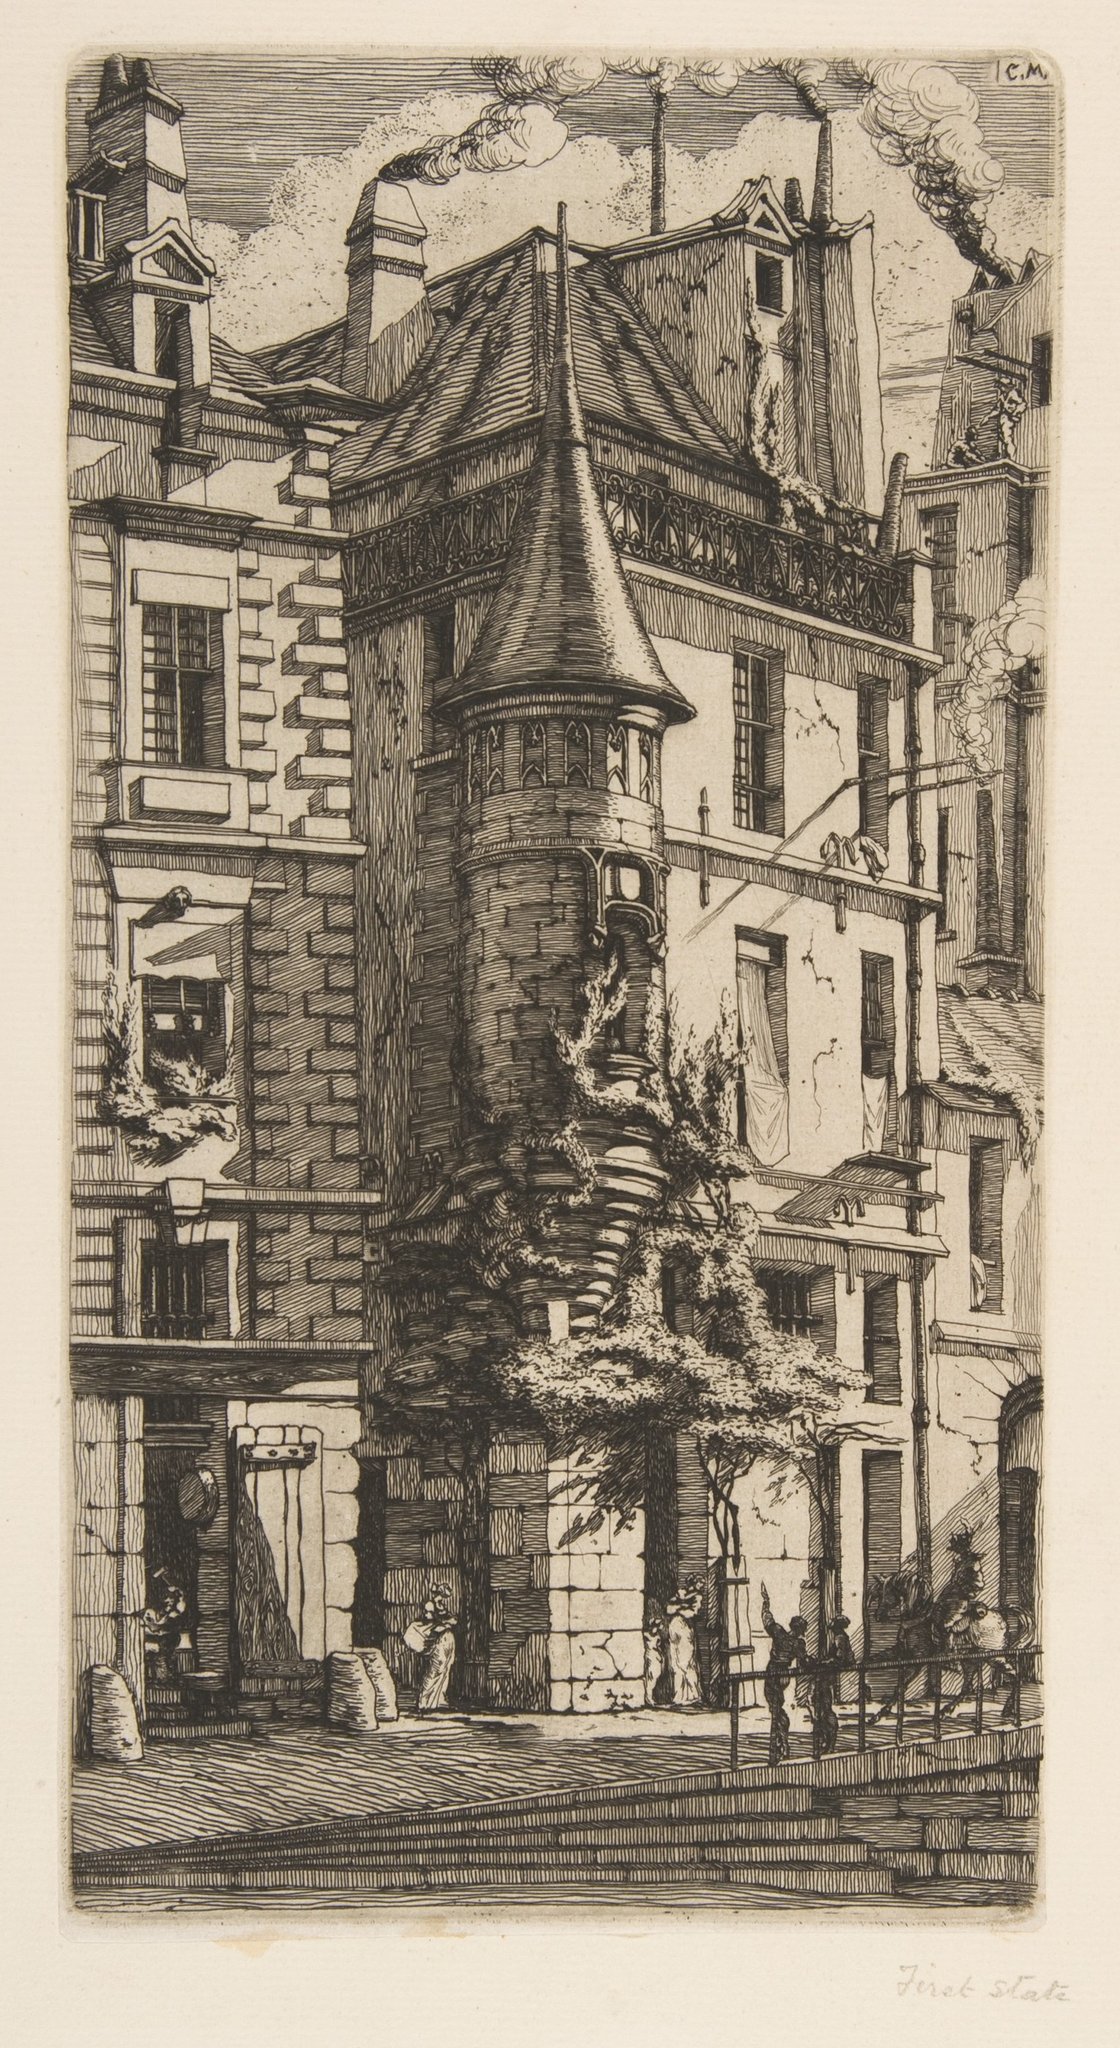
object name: print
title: House with a Turret, rue de la Tixéranderie, Paris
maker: charles meryon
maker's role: artist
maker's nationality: french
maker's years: 1821-1868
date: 1852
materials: paper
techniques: etching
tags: houses,paris